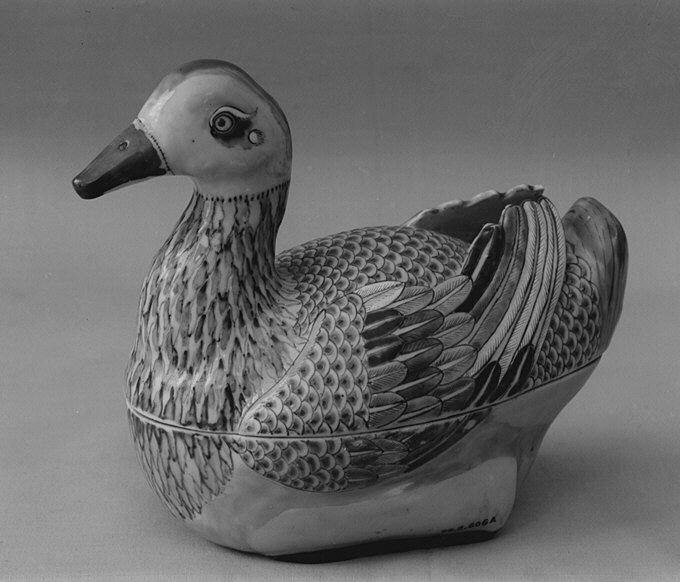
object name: tureen with cover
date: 1760-1770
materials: hard paste porcelain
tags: ducks